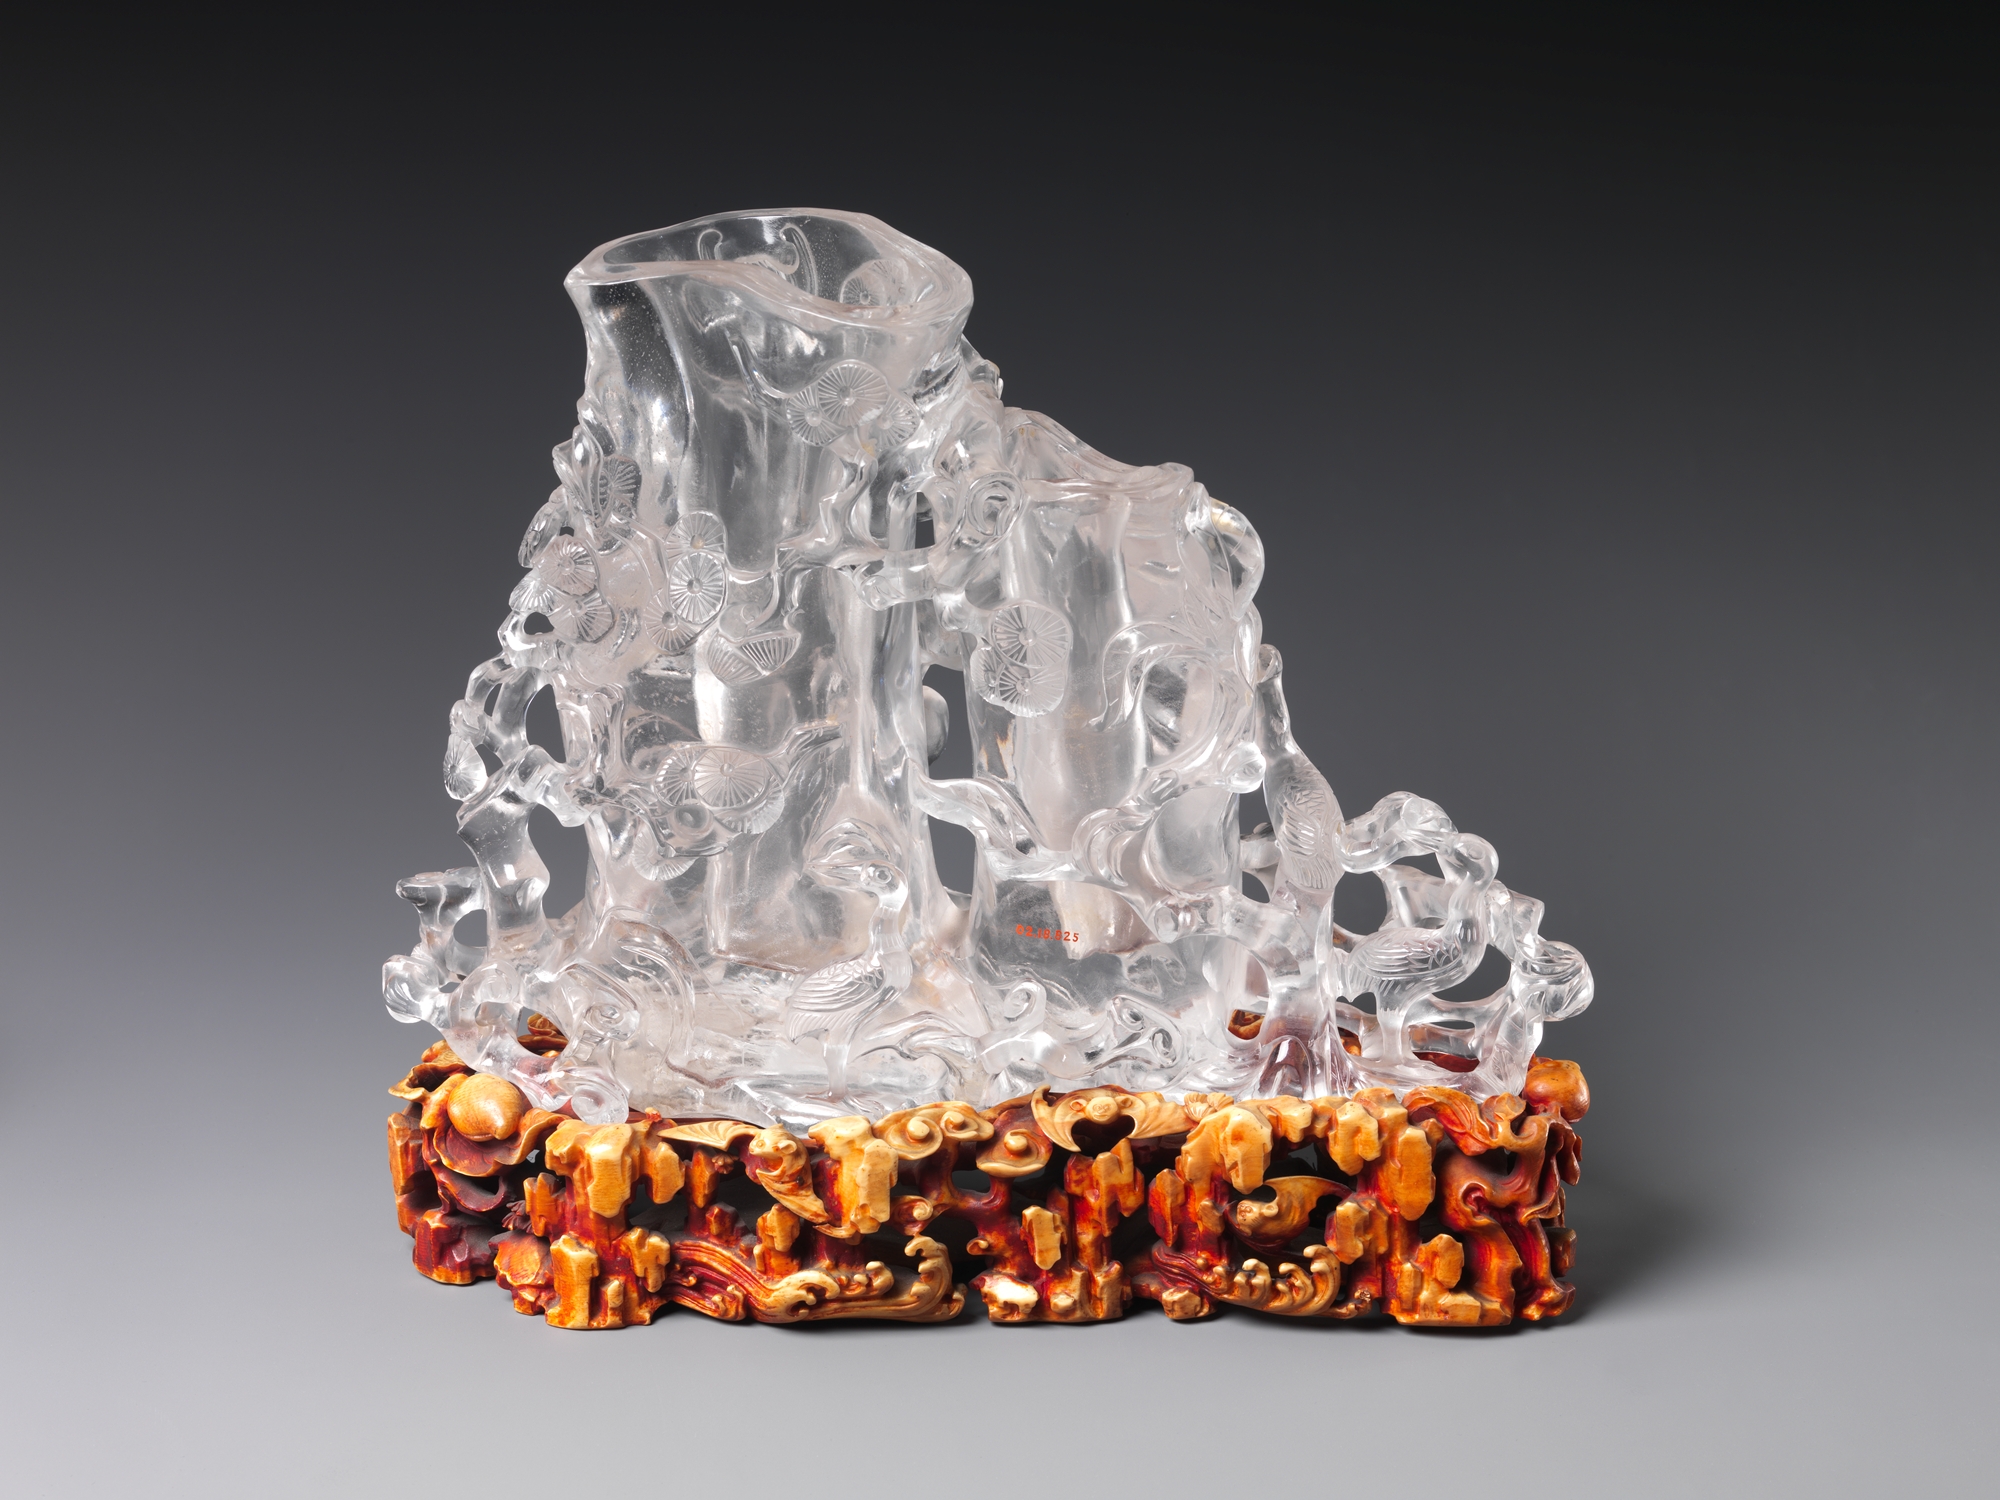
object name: flower holder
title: Flower holder in the form of pine and bamboo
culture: chinese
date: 1701-1800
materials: quartz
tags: bamboo